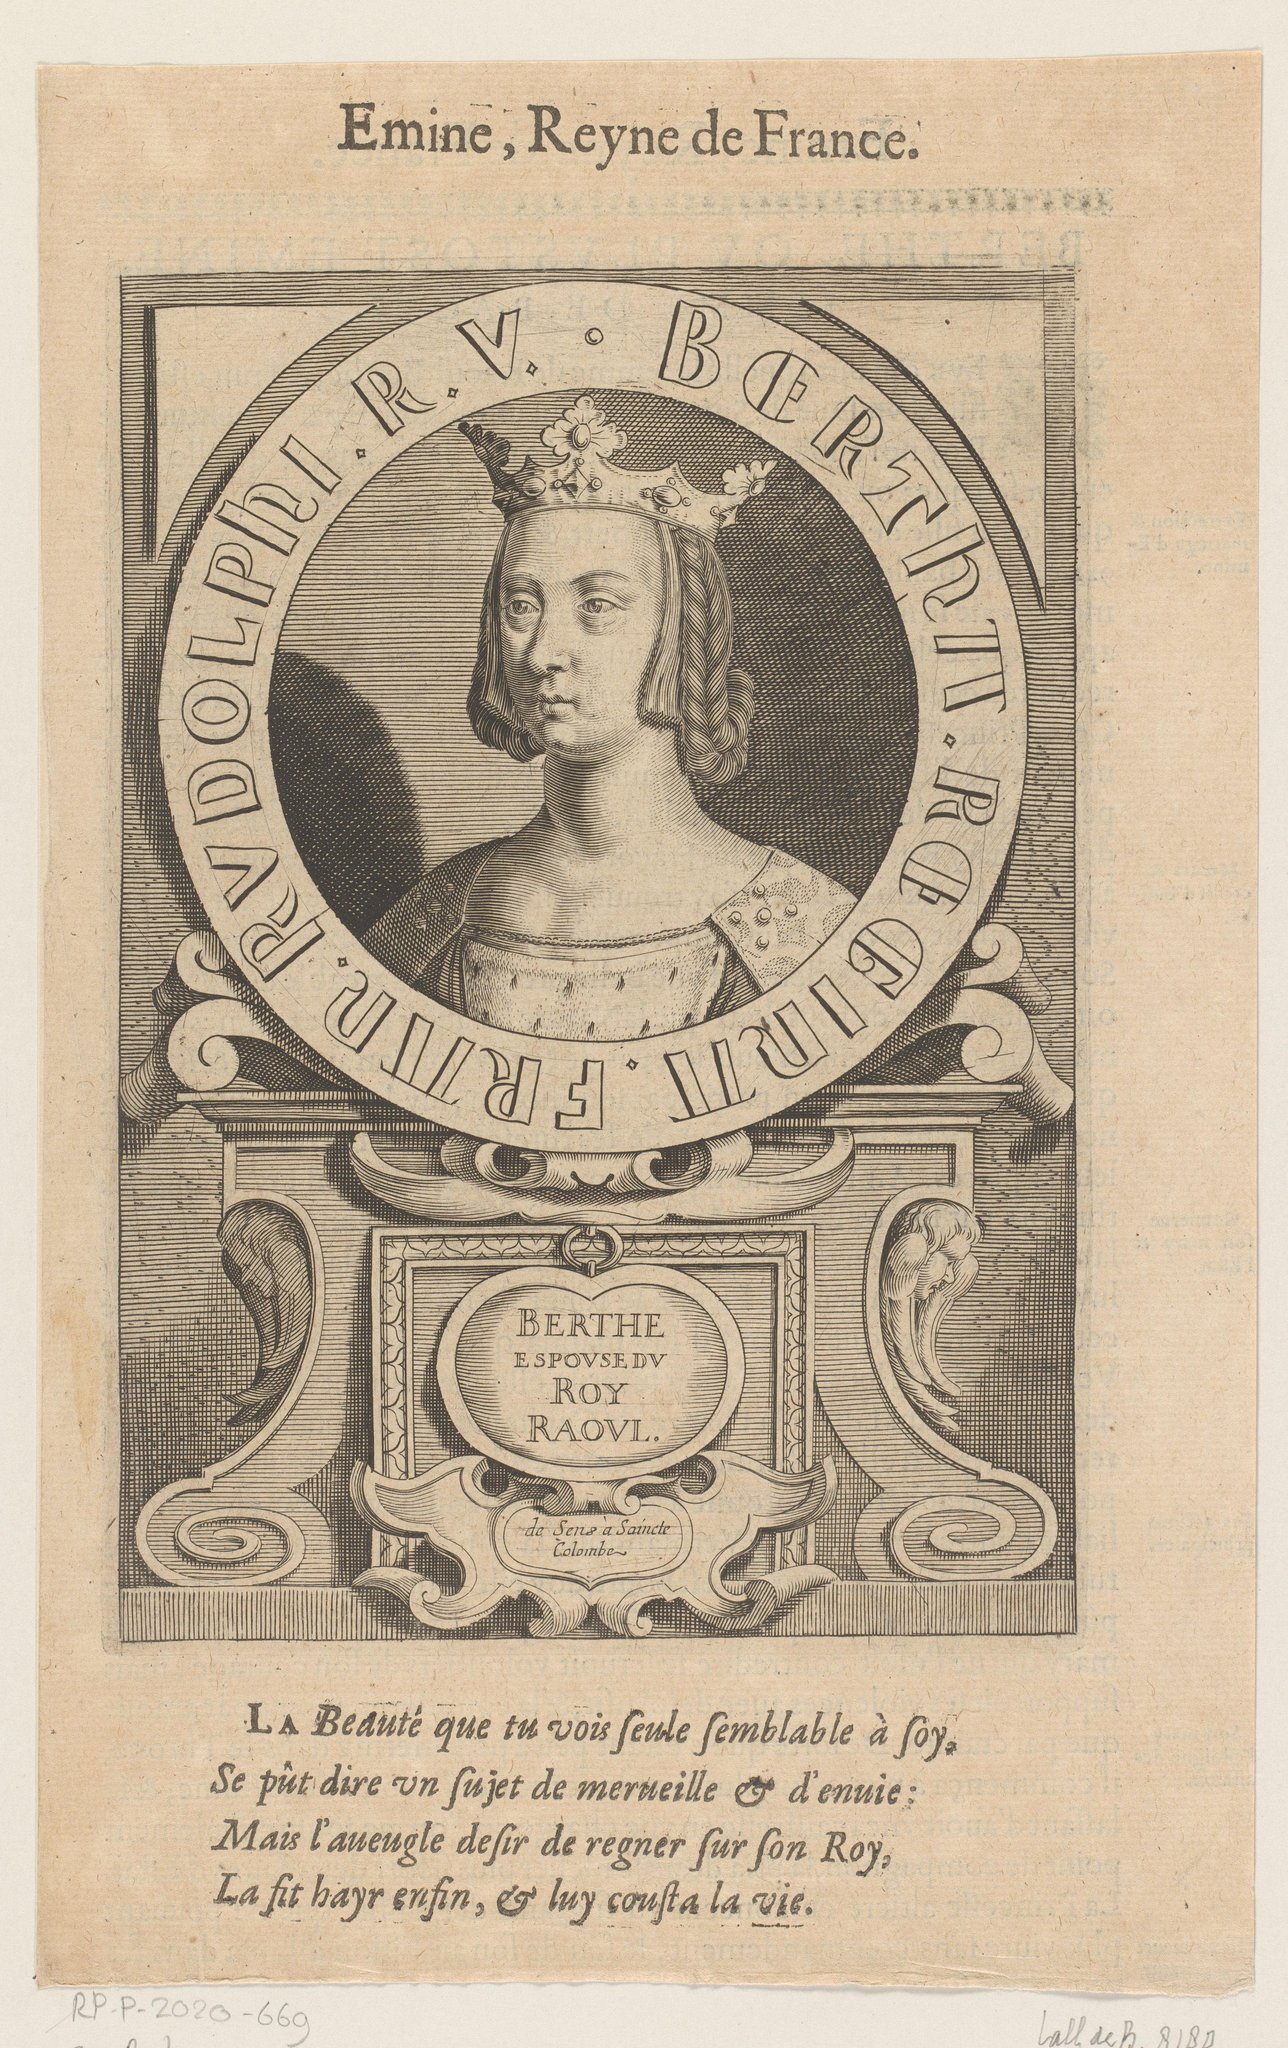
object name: print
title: Berthe espouse du roy Raoul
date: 1643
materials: paper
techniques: engraving, letterpress printing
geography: paris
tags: historical persons, queen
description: Prent uit: Eudes de Mézeray, François. Histoire de France, depuis Faramond jusqu’au regne de Louis le Juste (...). 3 dln. Parijs: Mathieu Guillemot, 1643, dl. 1. Prent waarschijnlijk voor het eerst verschenen in: Bie, Jacques de. Les vrais portraits des rois de France (...). Parijs: Jacques de Bie en Pierre Rocolet, 1634. Prent ook gebruikt in latere publicaties.